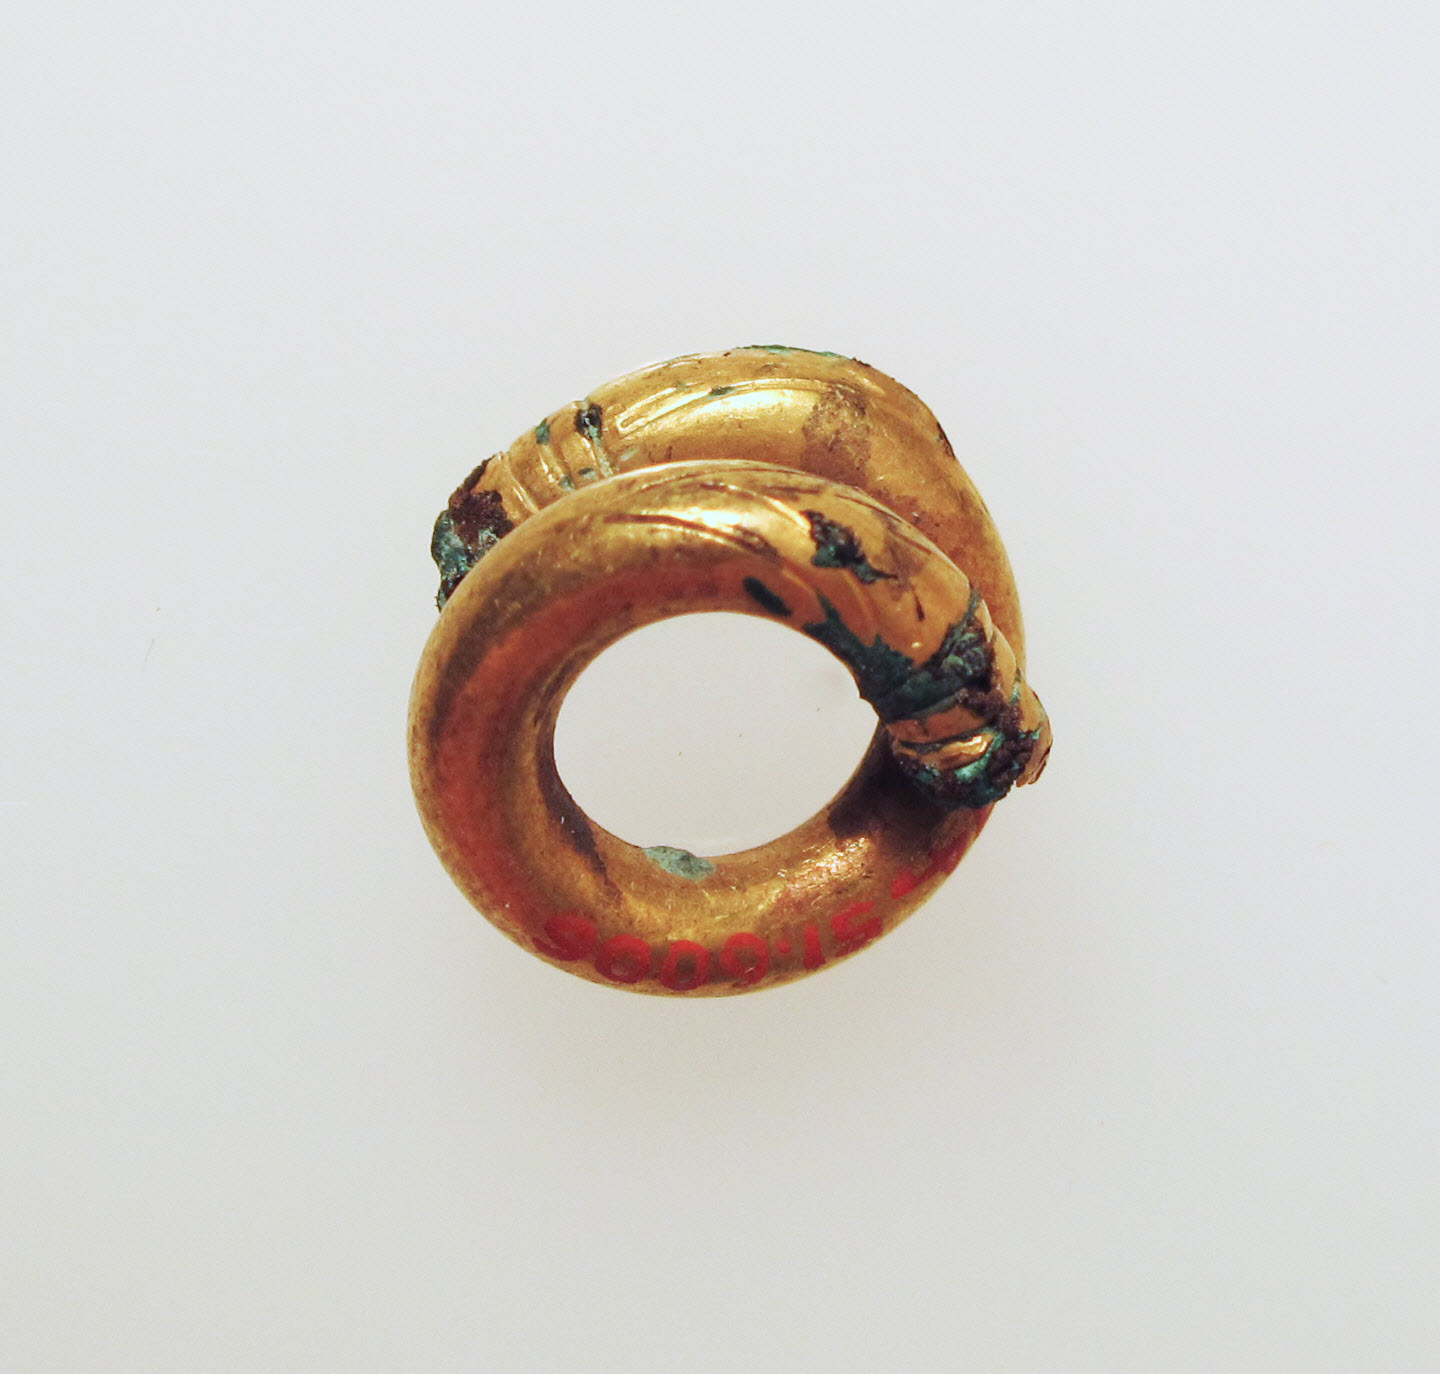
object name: earring or spiral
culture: cypriot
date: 500-401 BCE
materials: bronze, gold